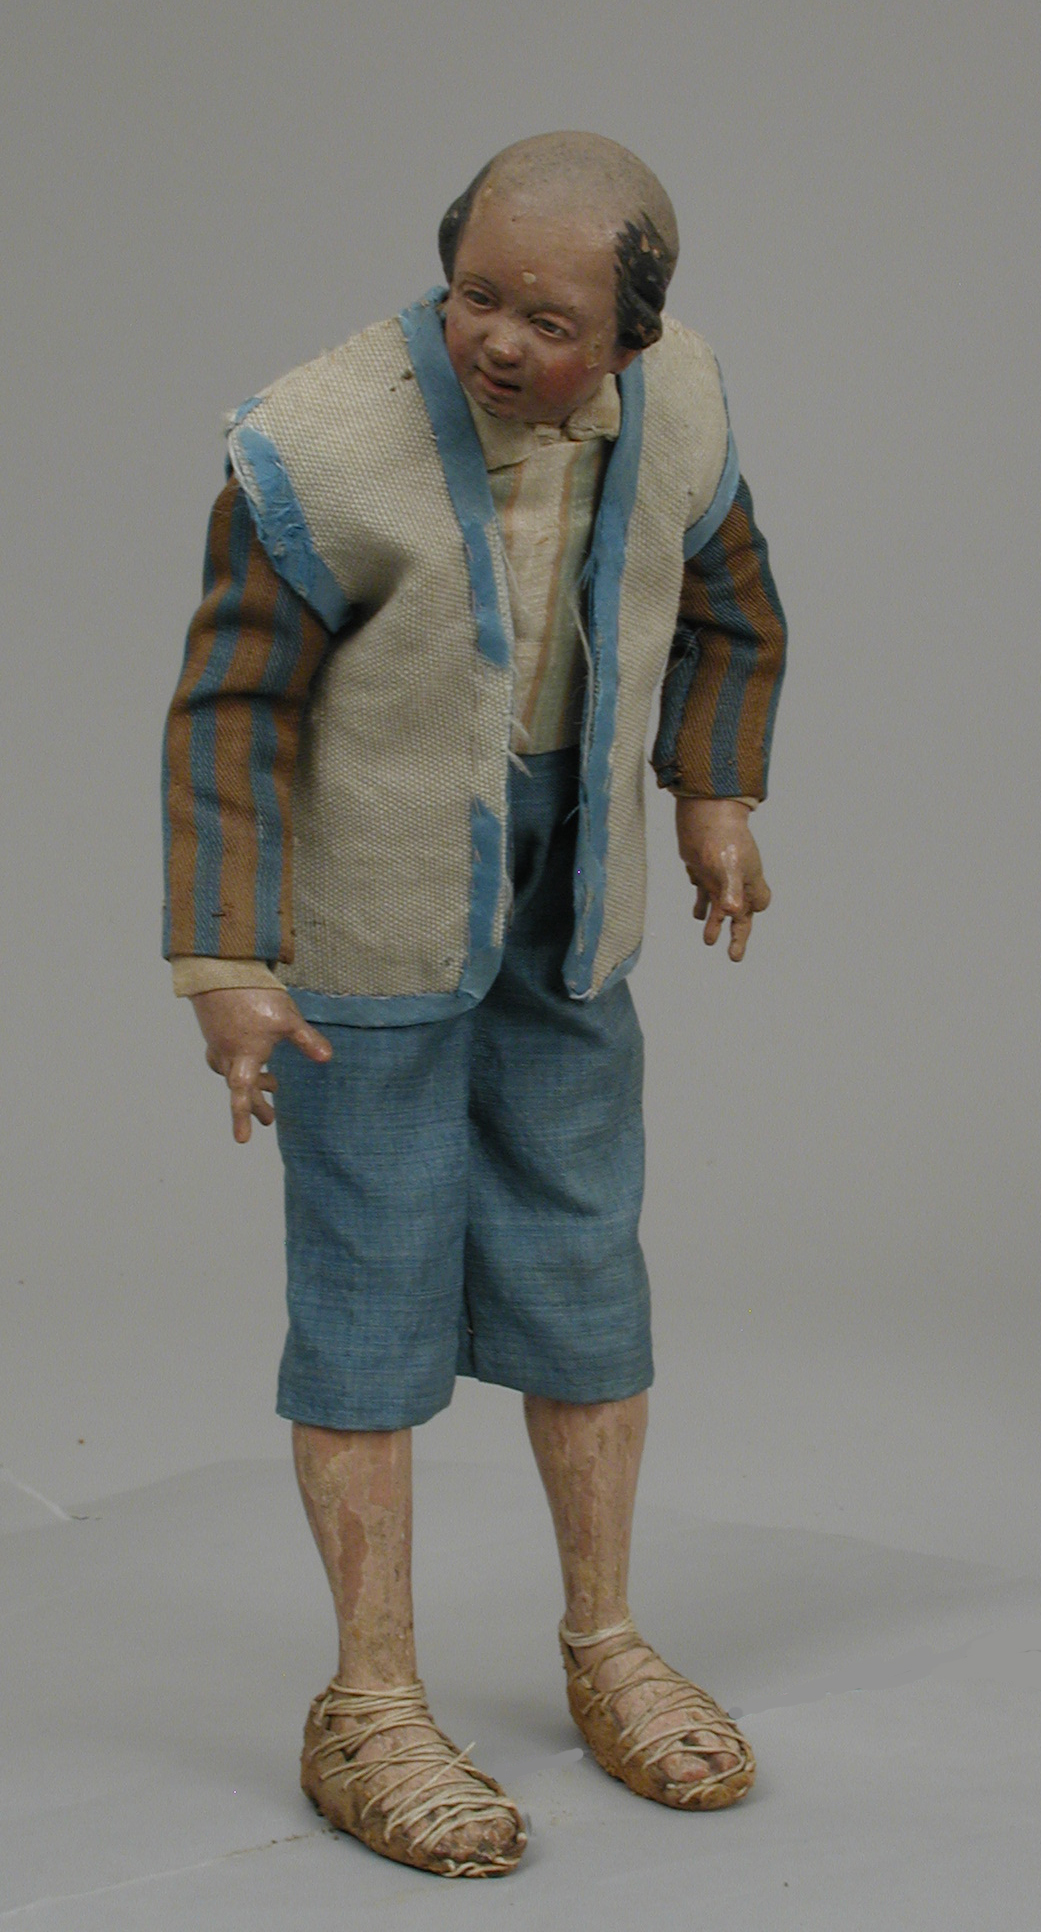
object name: crèche figure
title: Shepherd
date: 1751-1800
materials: cotton, leather, silk, terracotta, fiber, metal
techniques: polychrome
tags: men,shepherds